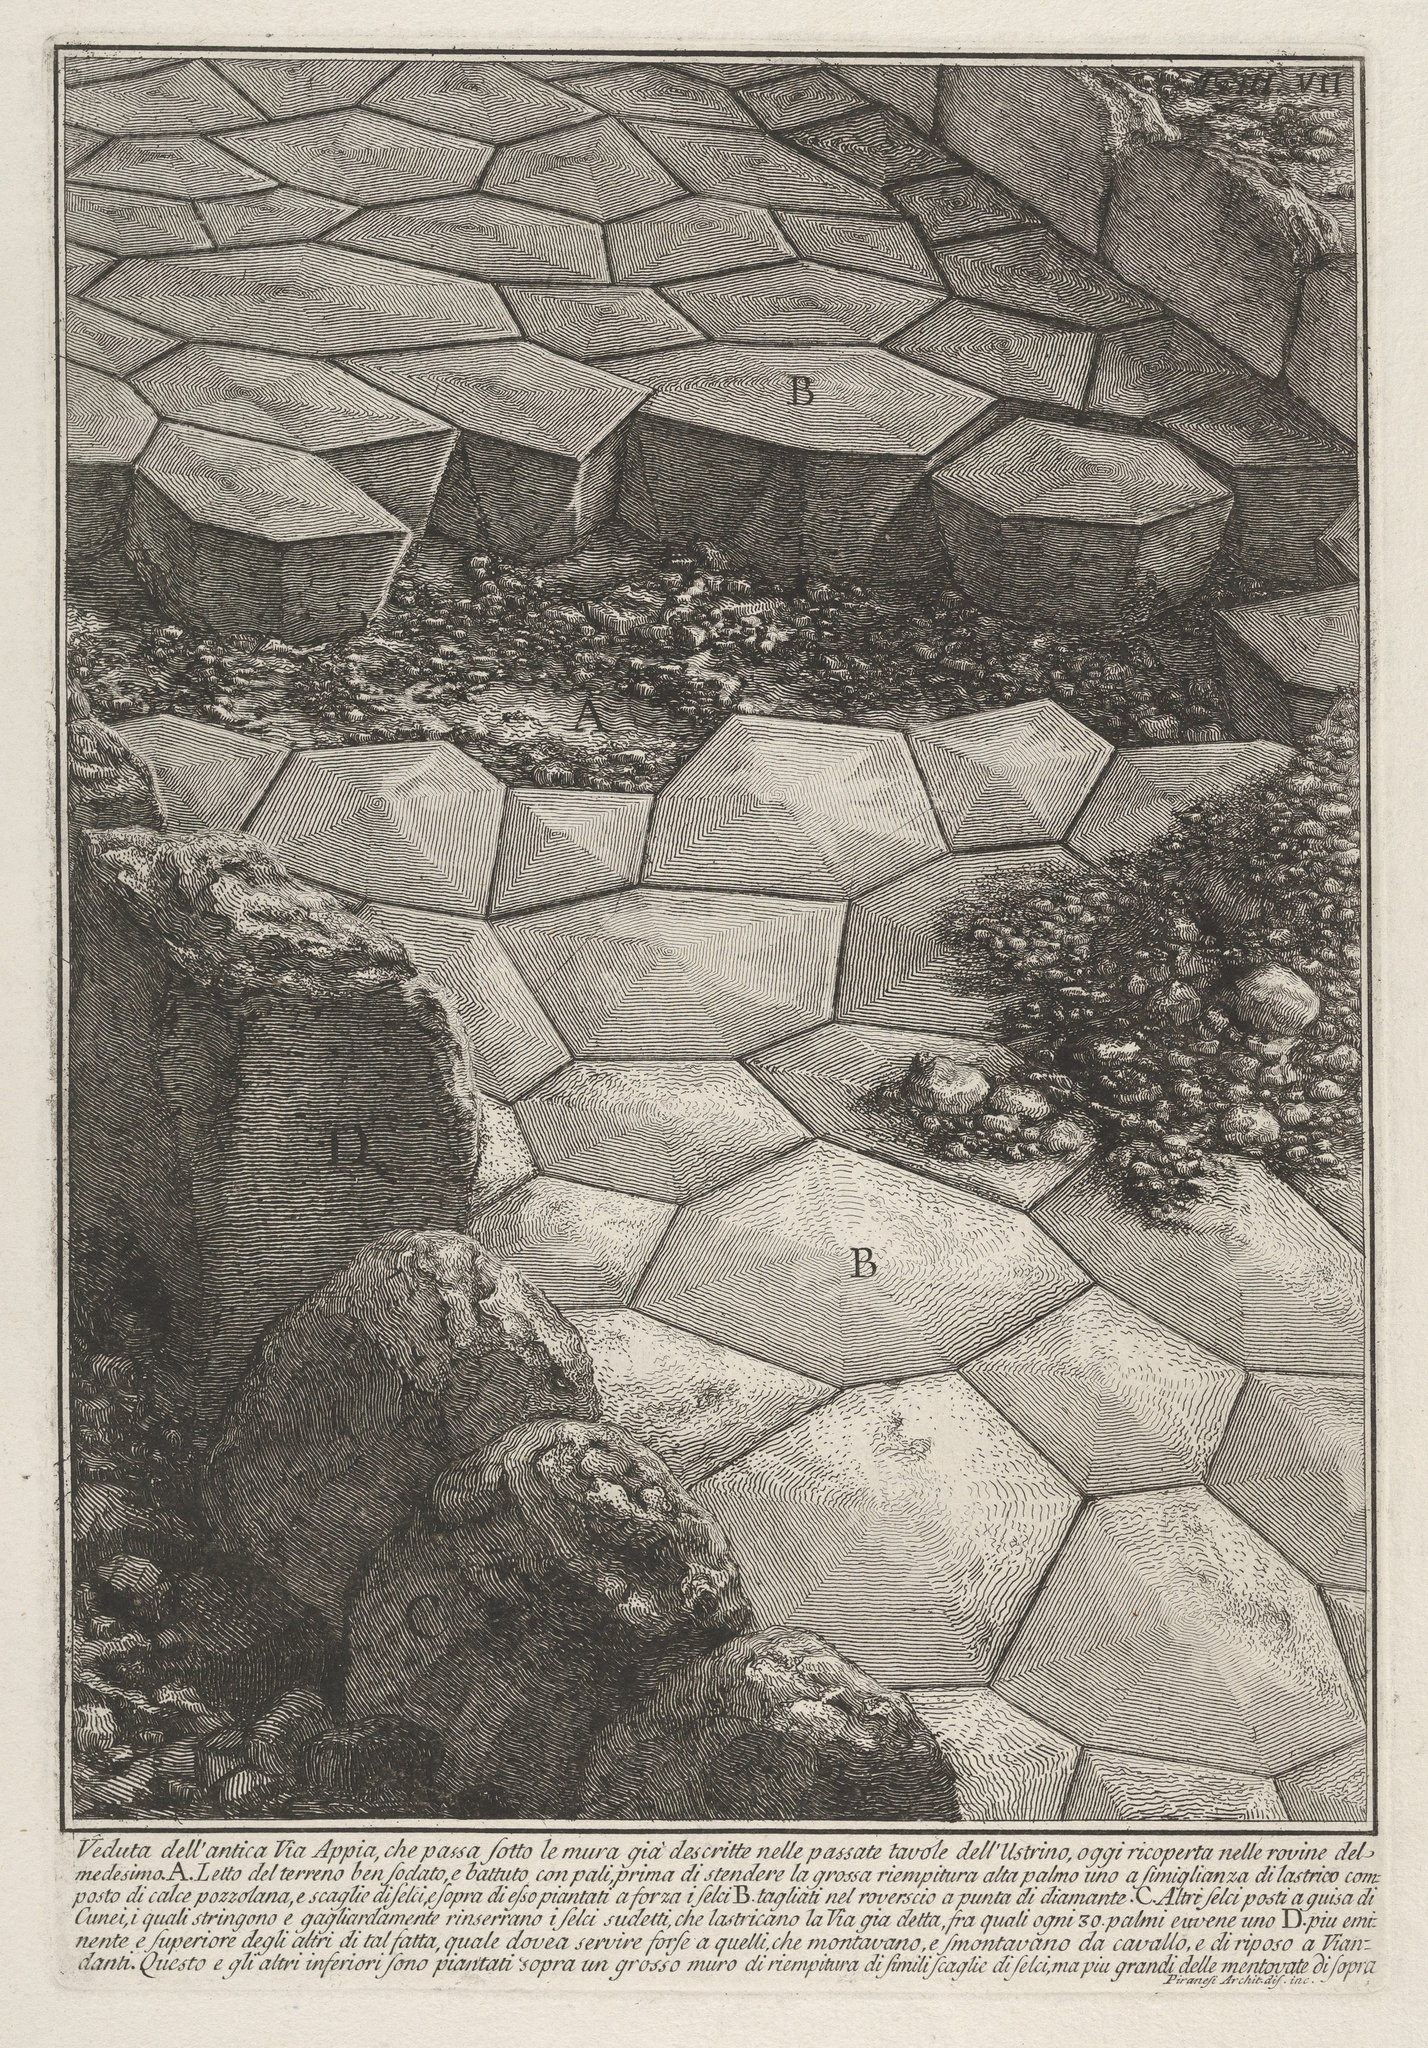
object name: print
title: View of the stone pavement of the Appian Way (Veduta dell'antica Via Appia), from "Le Antichità Romane"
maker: giovanni battista piranesi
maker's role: artist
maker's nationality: italian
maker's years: 1720-1778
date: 1756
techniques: etching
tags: roads